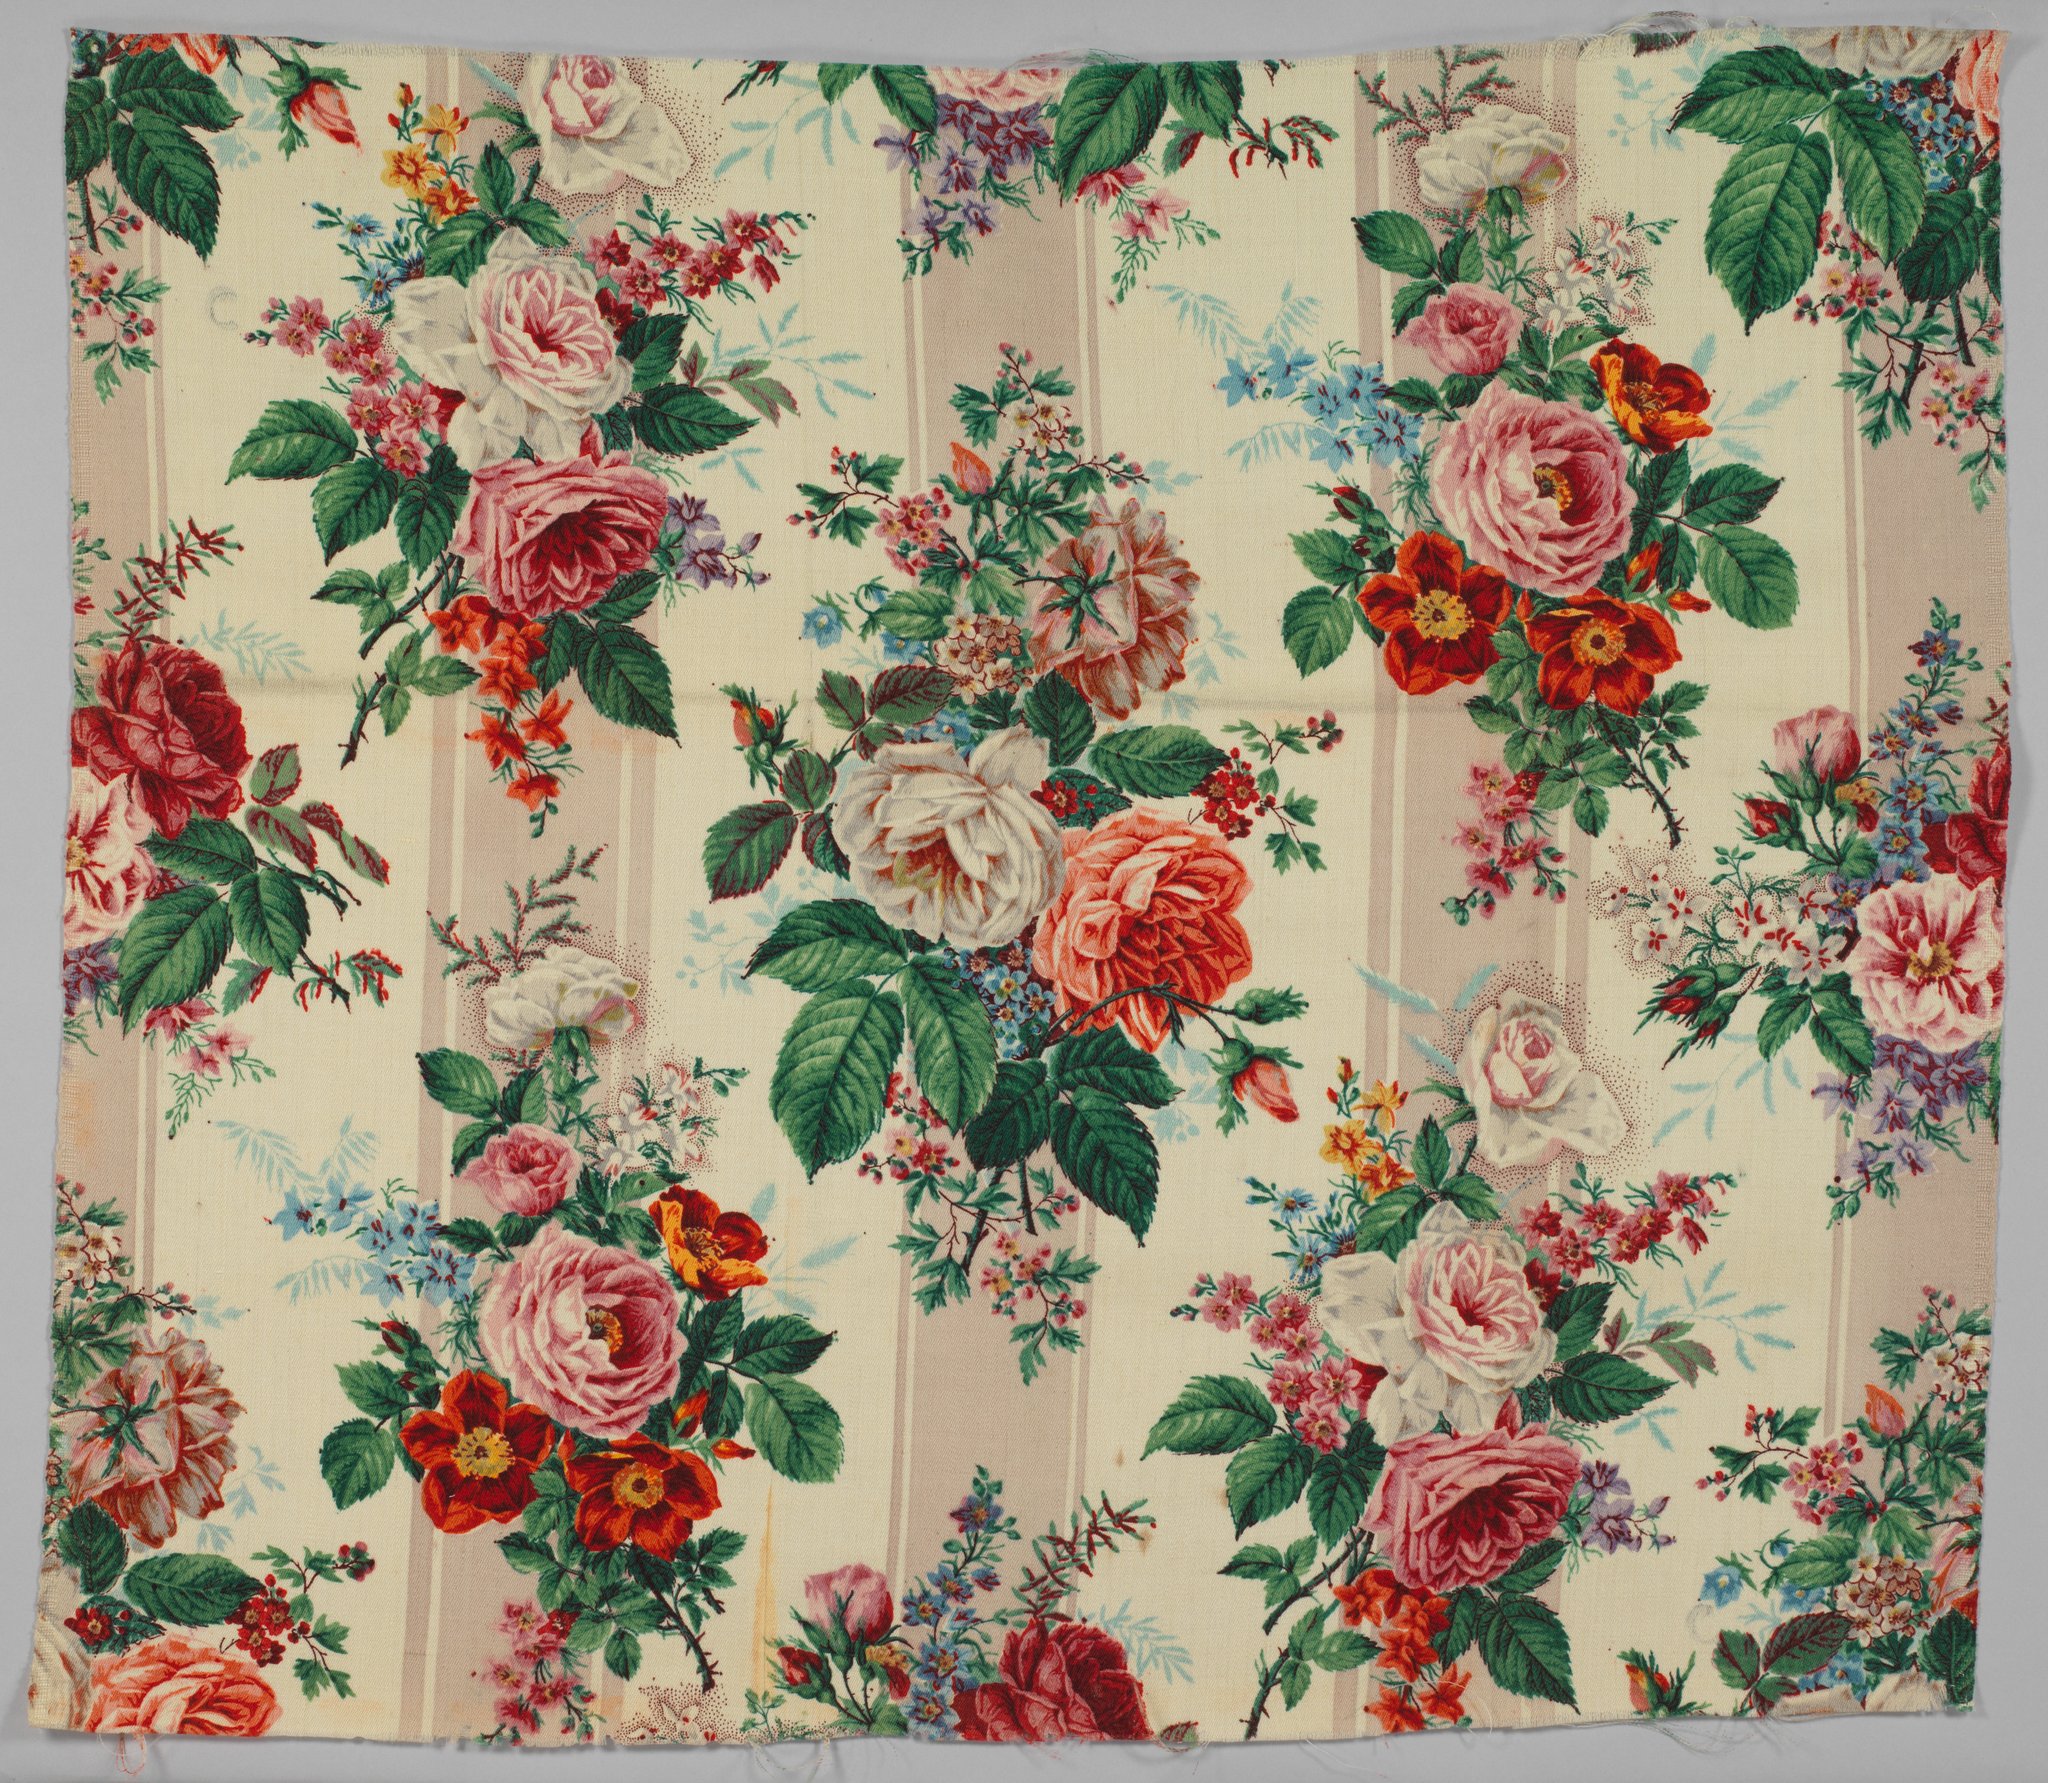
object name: sample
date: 1850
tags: flowers